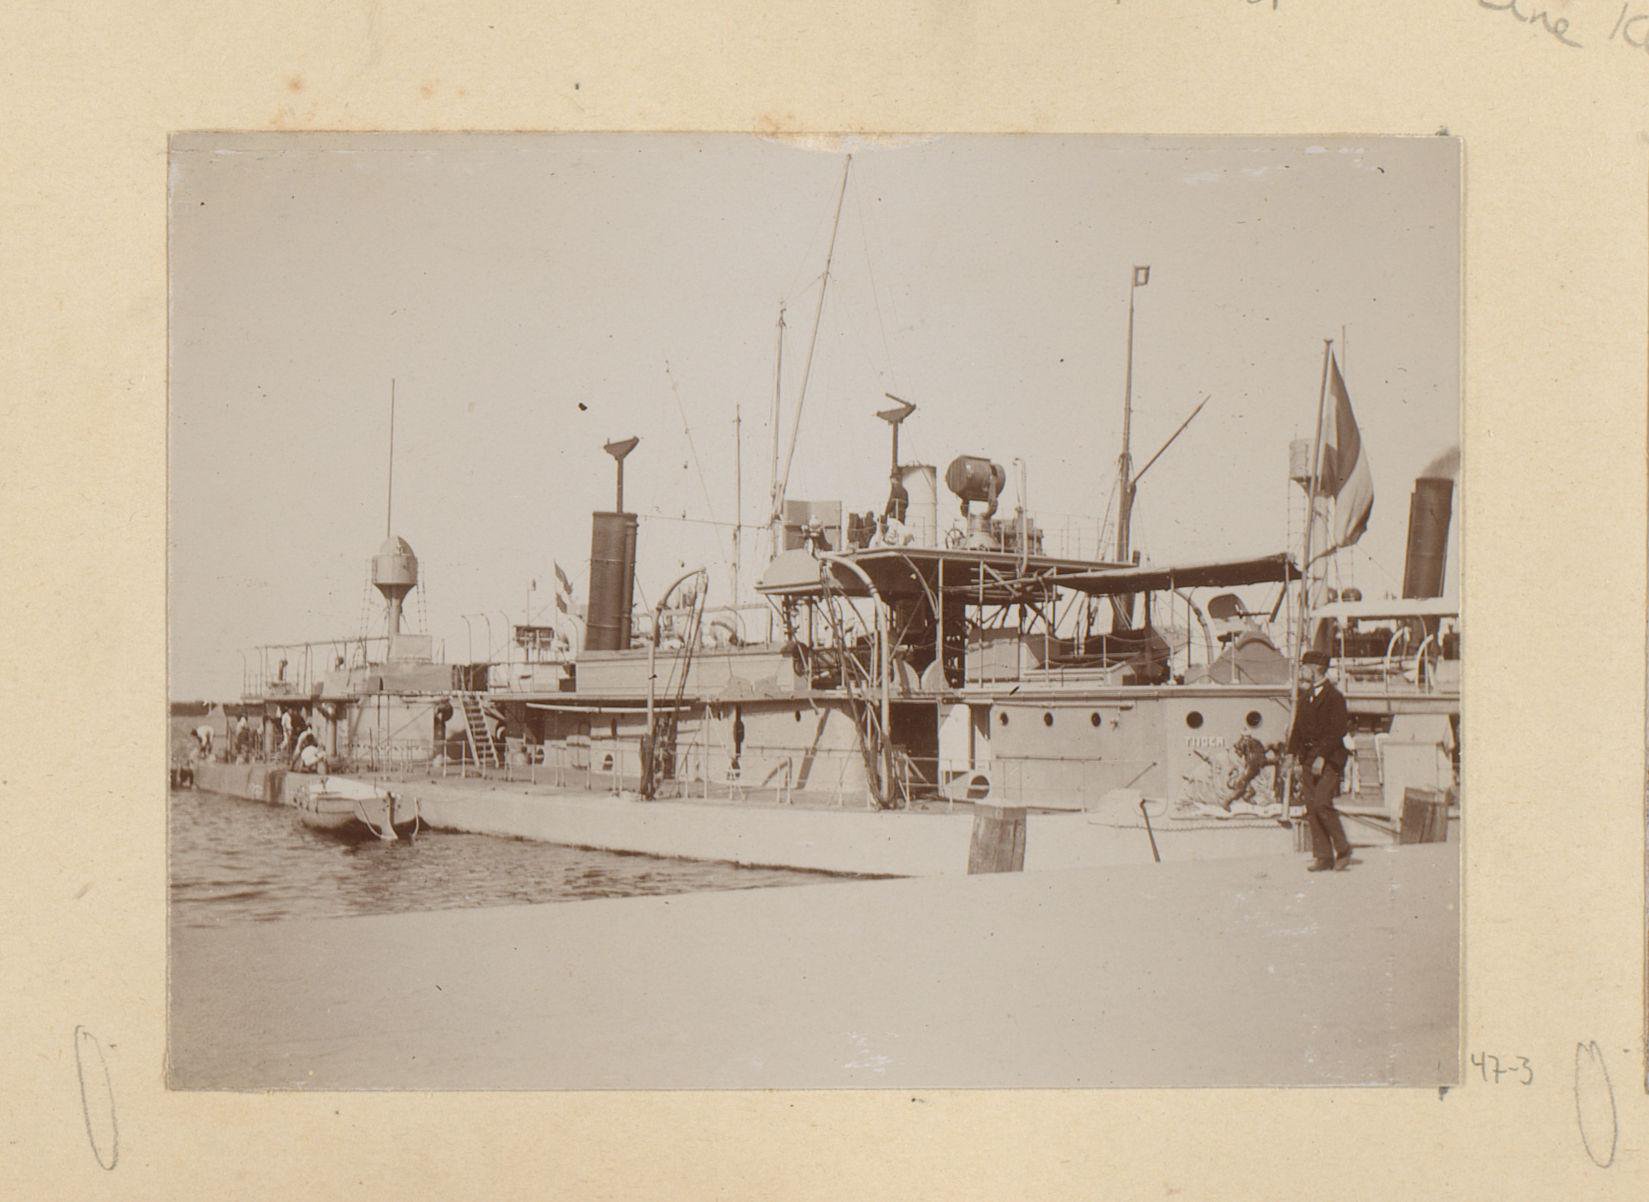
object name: album leaf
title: Schip aan een kade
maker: hendrik herman van den berg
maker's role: amateurfotograaf, jurist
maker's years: 1875-1944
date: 1890-1894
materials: paper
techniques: collodion silver print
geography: amsterdam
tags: ships (in general), pier, quay, wharf, amsterdam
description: Foto 3 op albumblad 47 uit album "Amsterdam 1890-1894".